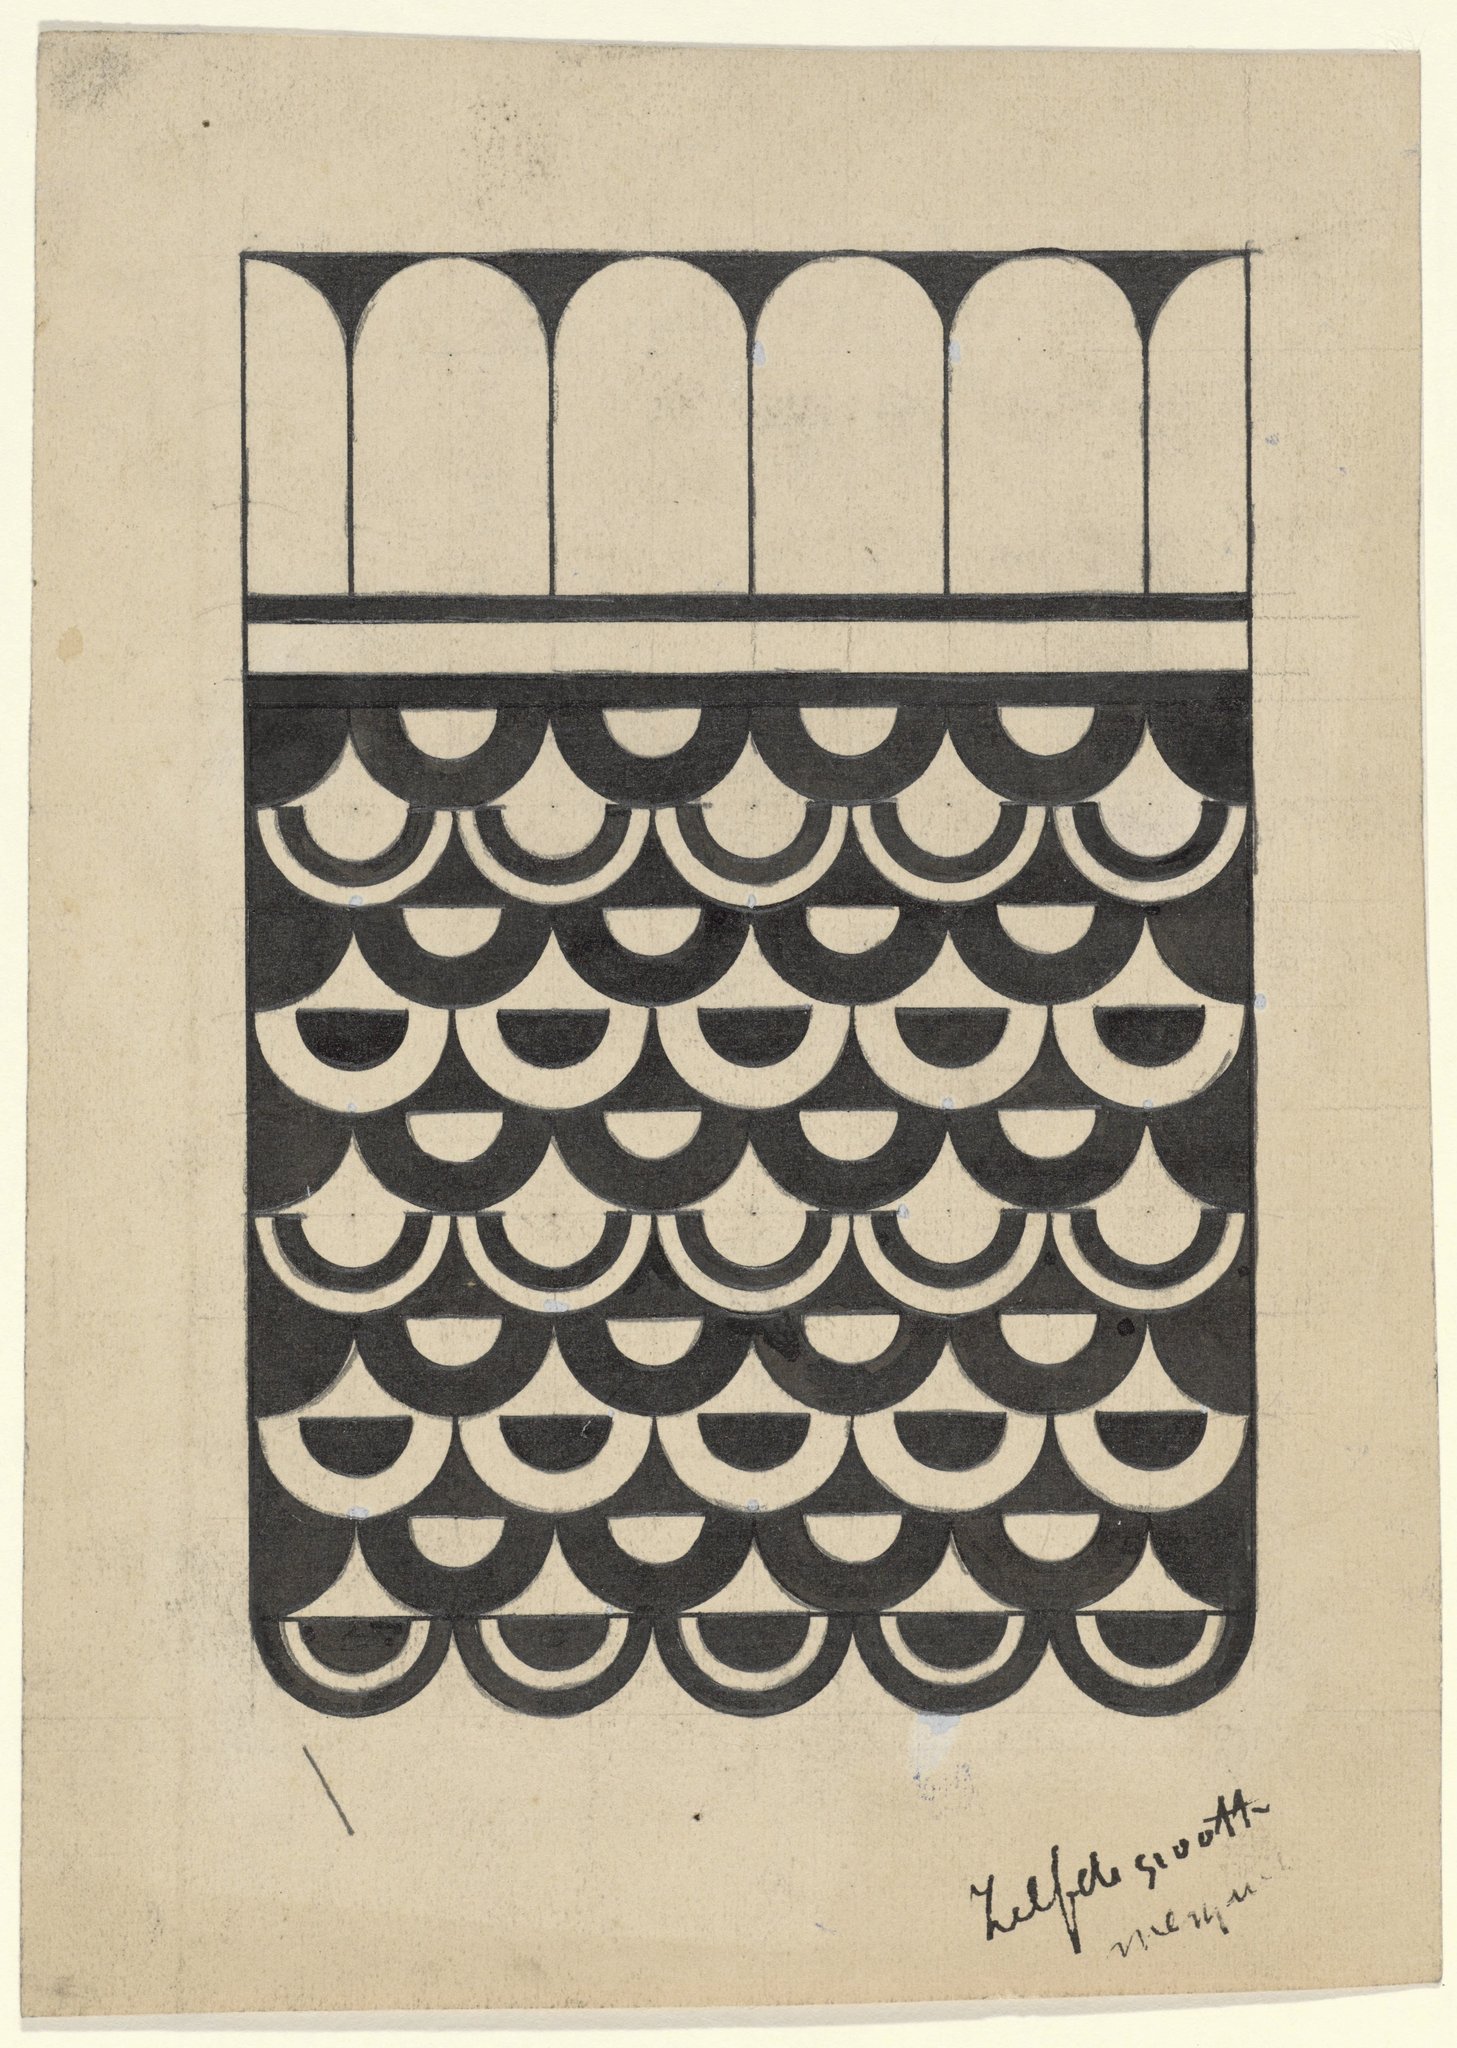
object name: drawing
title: Ornament van schubben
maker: samuel jessurun de mesquita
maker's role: draughtsman, print maker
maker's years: 1868-1944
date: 1878-1944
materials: chalk, ink, paper, pencil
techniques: brush, pen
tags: fishes, other ornament derived from animal forms